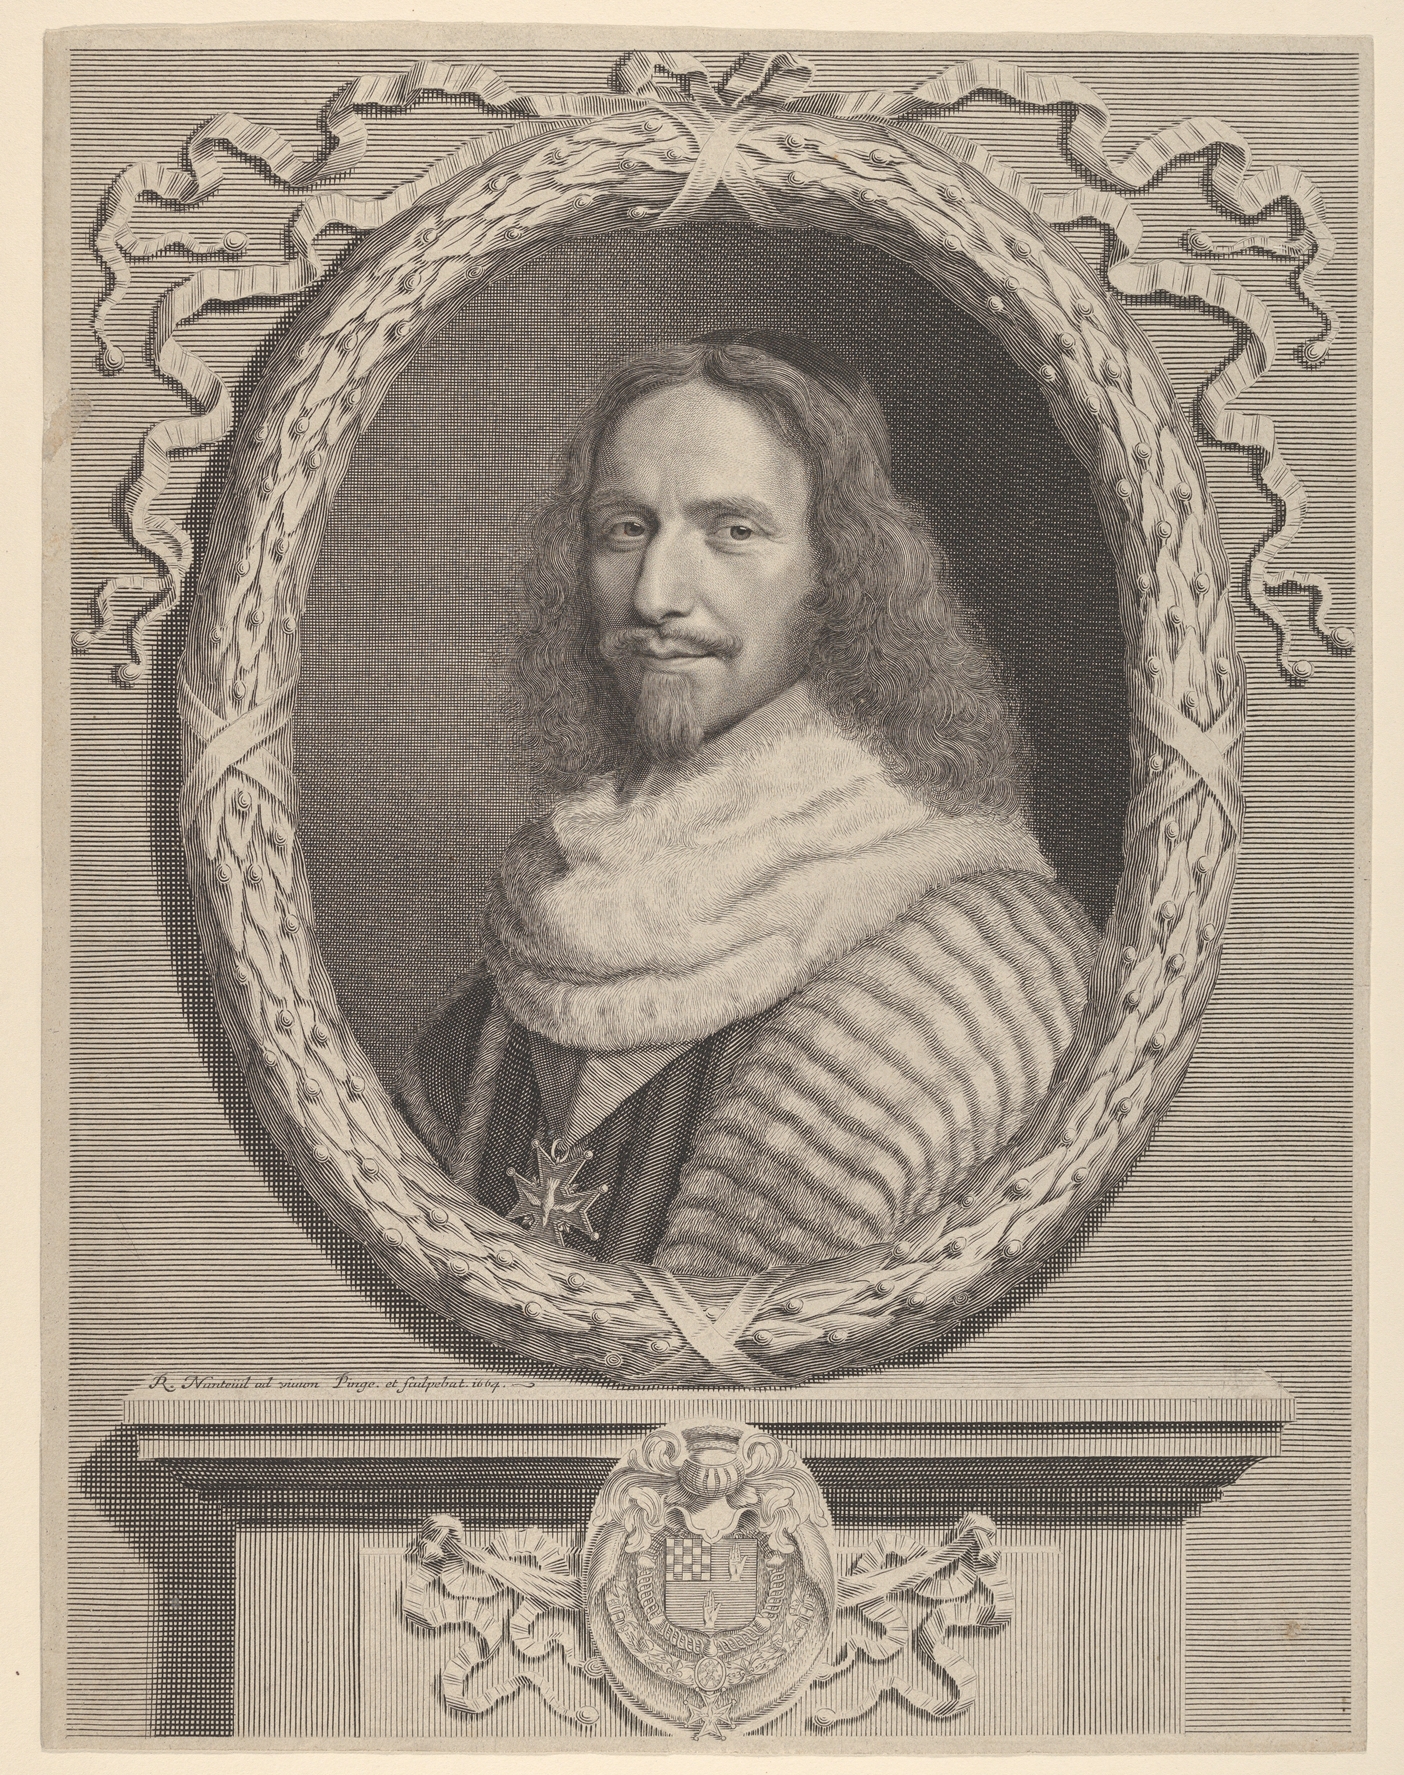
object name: print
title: Nicolas Potier de Novion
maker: robert nanteuil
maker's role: artist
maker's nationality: french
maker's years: 1623-1678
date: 1664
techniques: engraving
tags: men,portraits,coat of arms